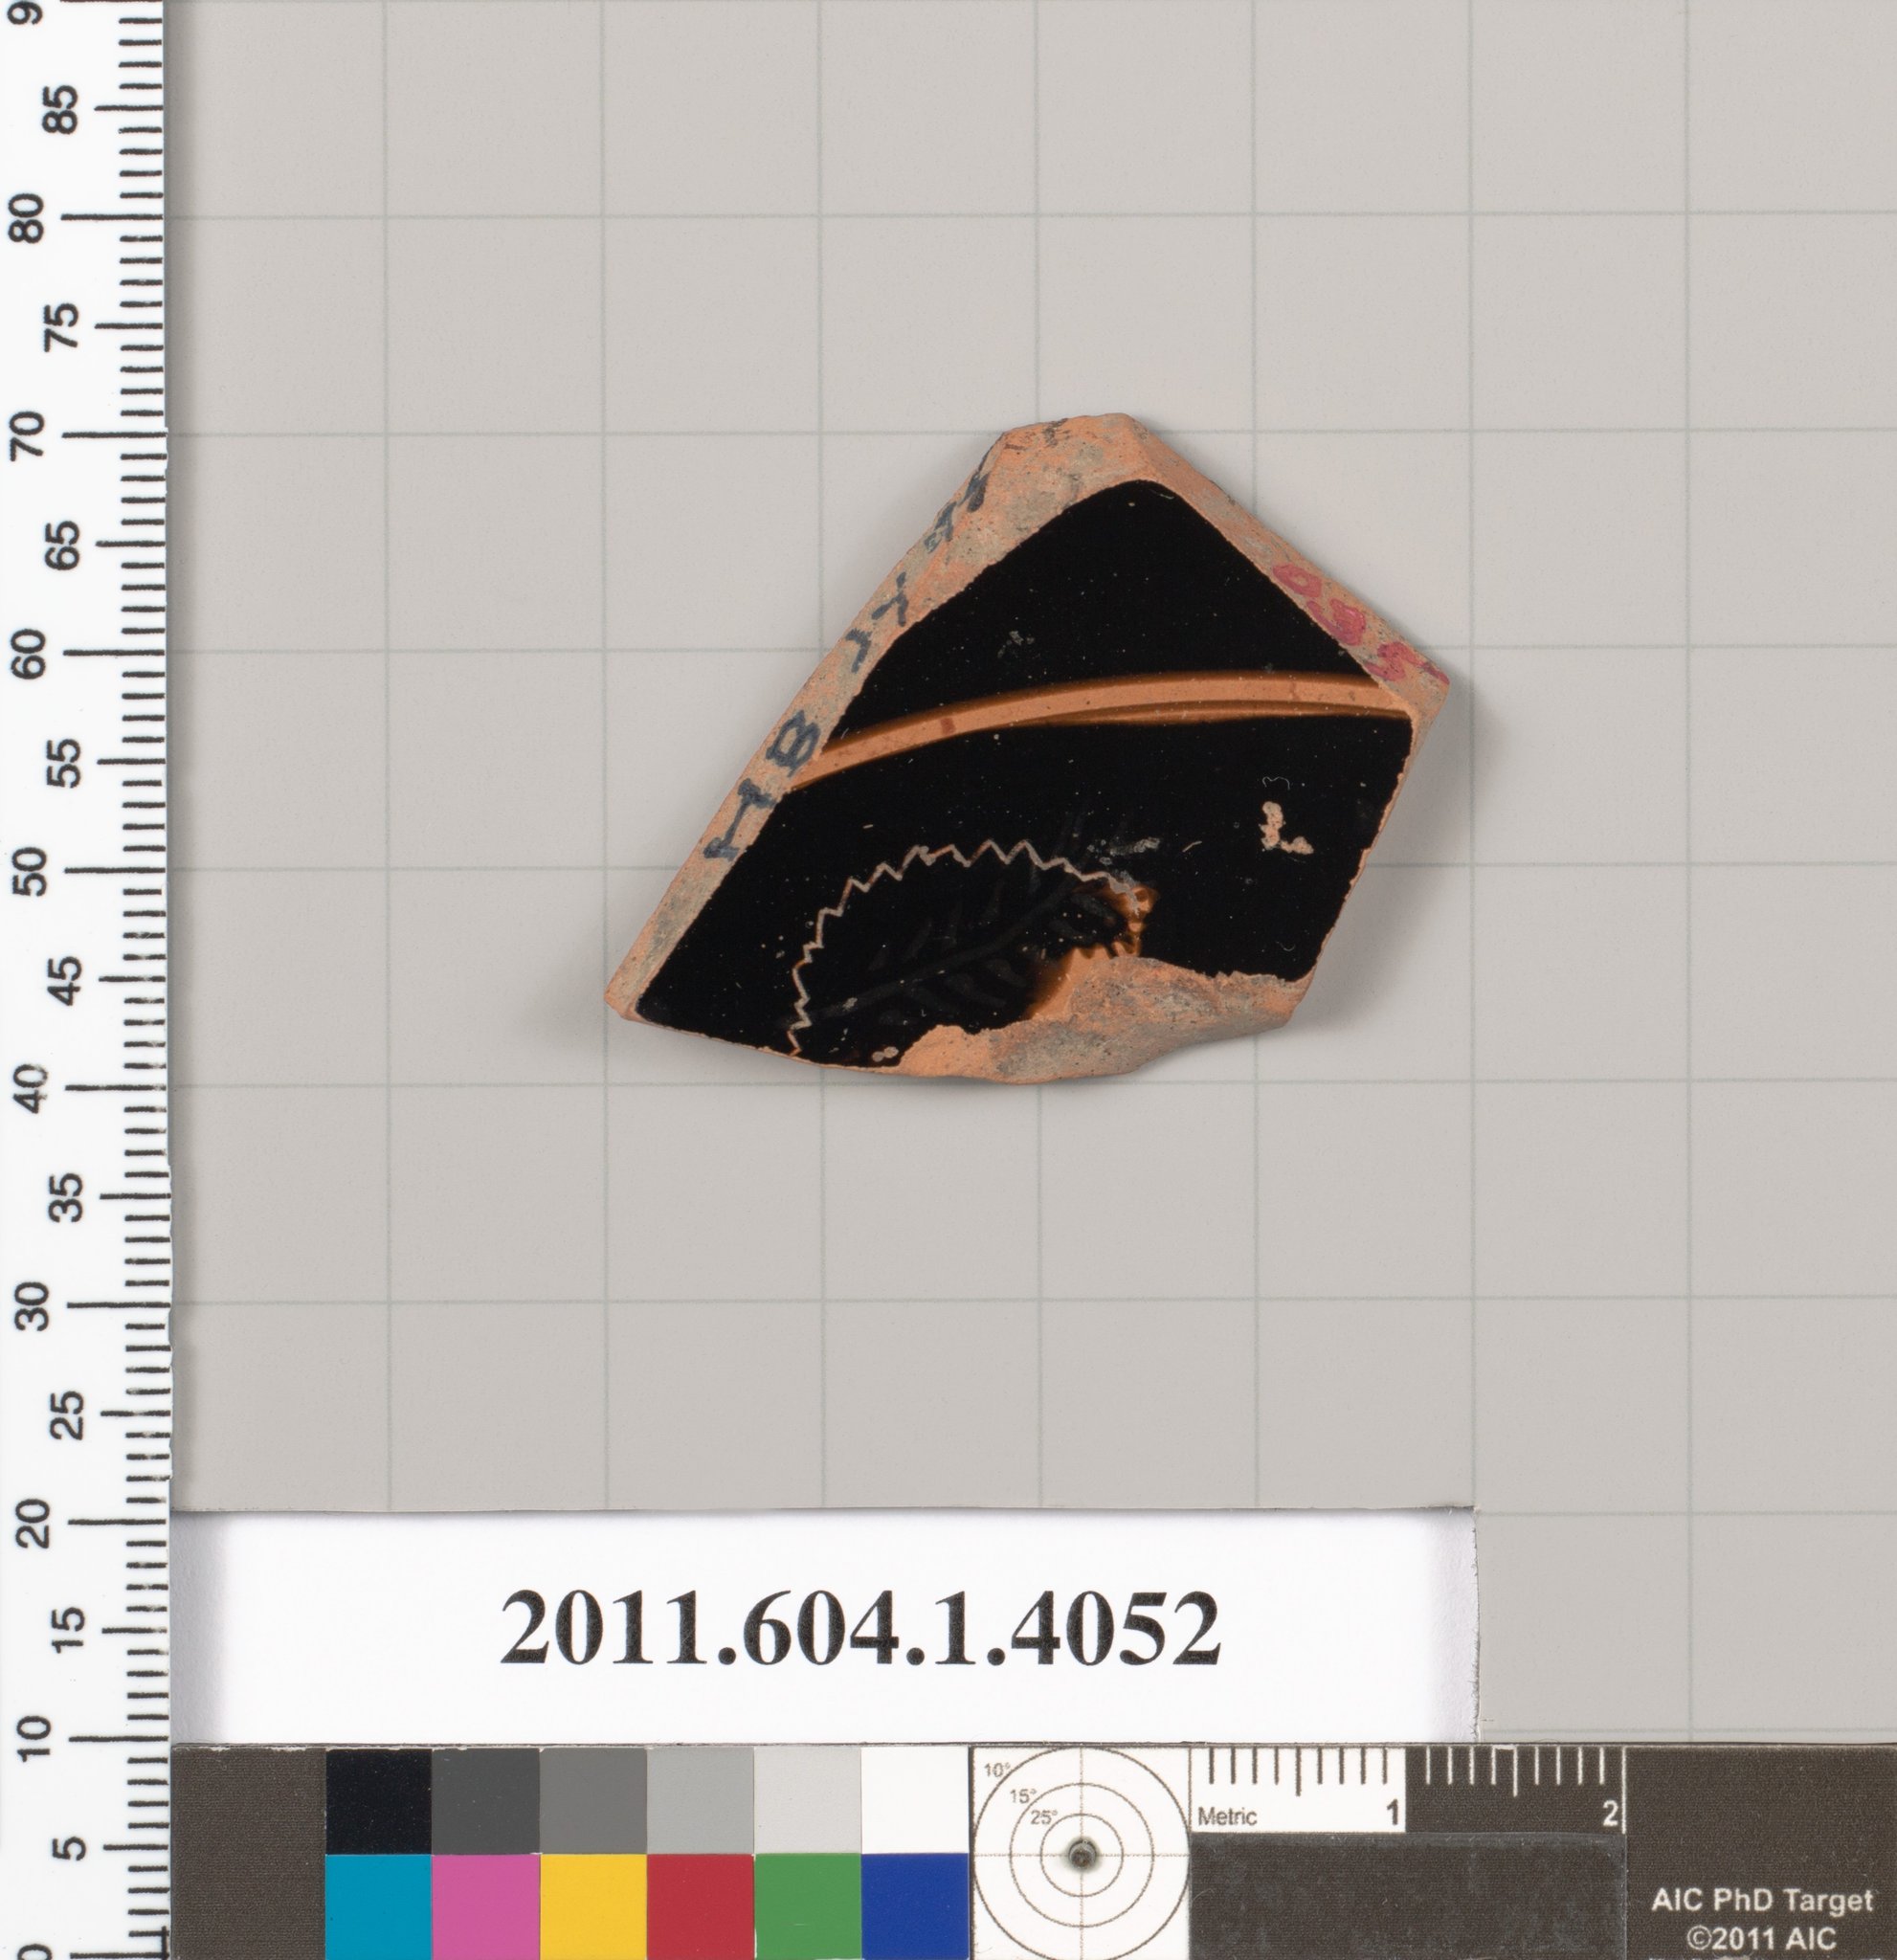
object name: kylix fragment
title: Terracotta fragment of a kylix (drinking cup)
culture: greek, attic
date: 520-500 BCE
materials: terracotta